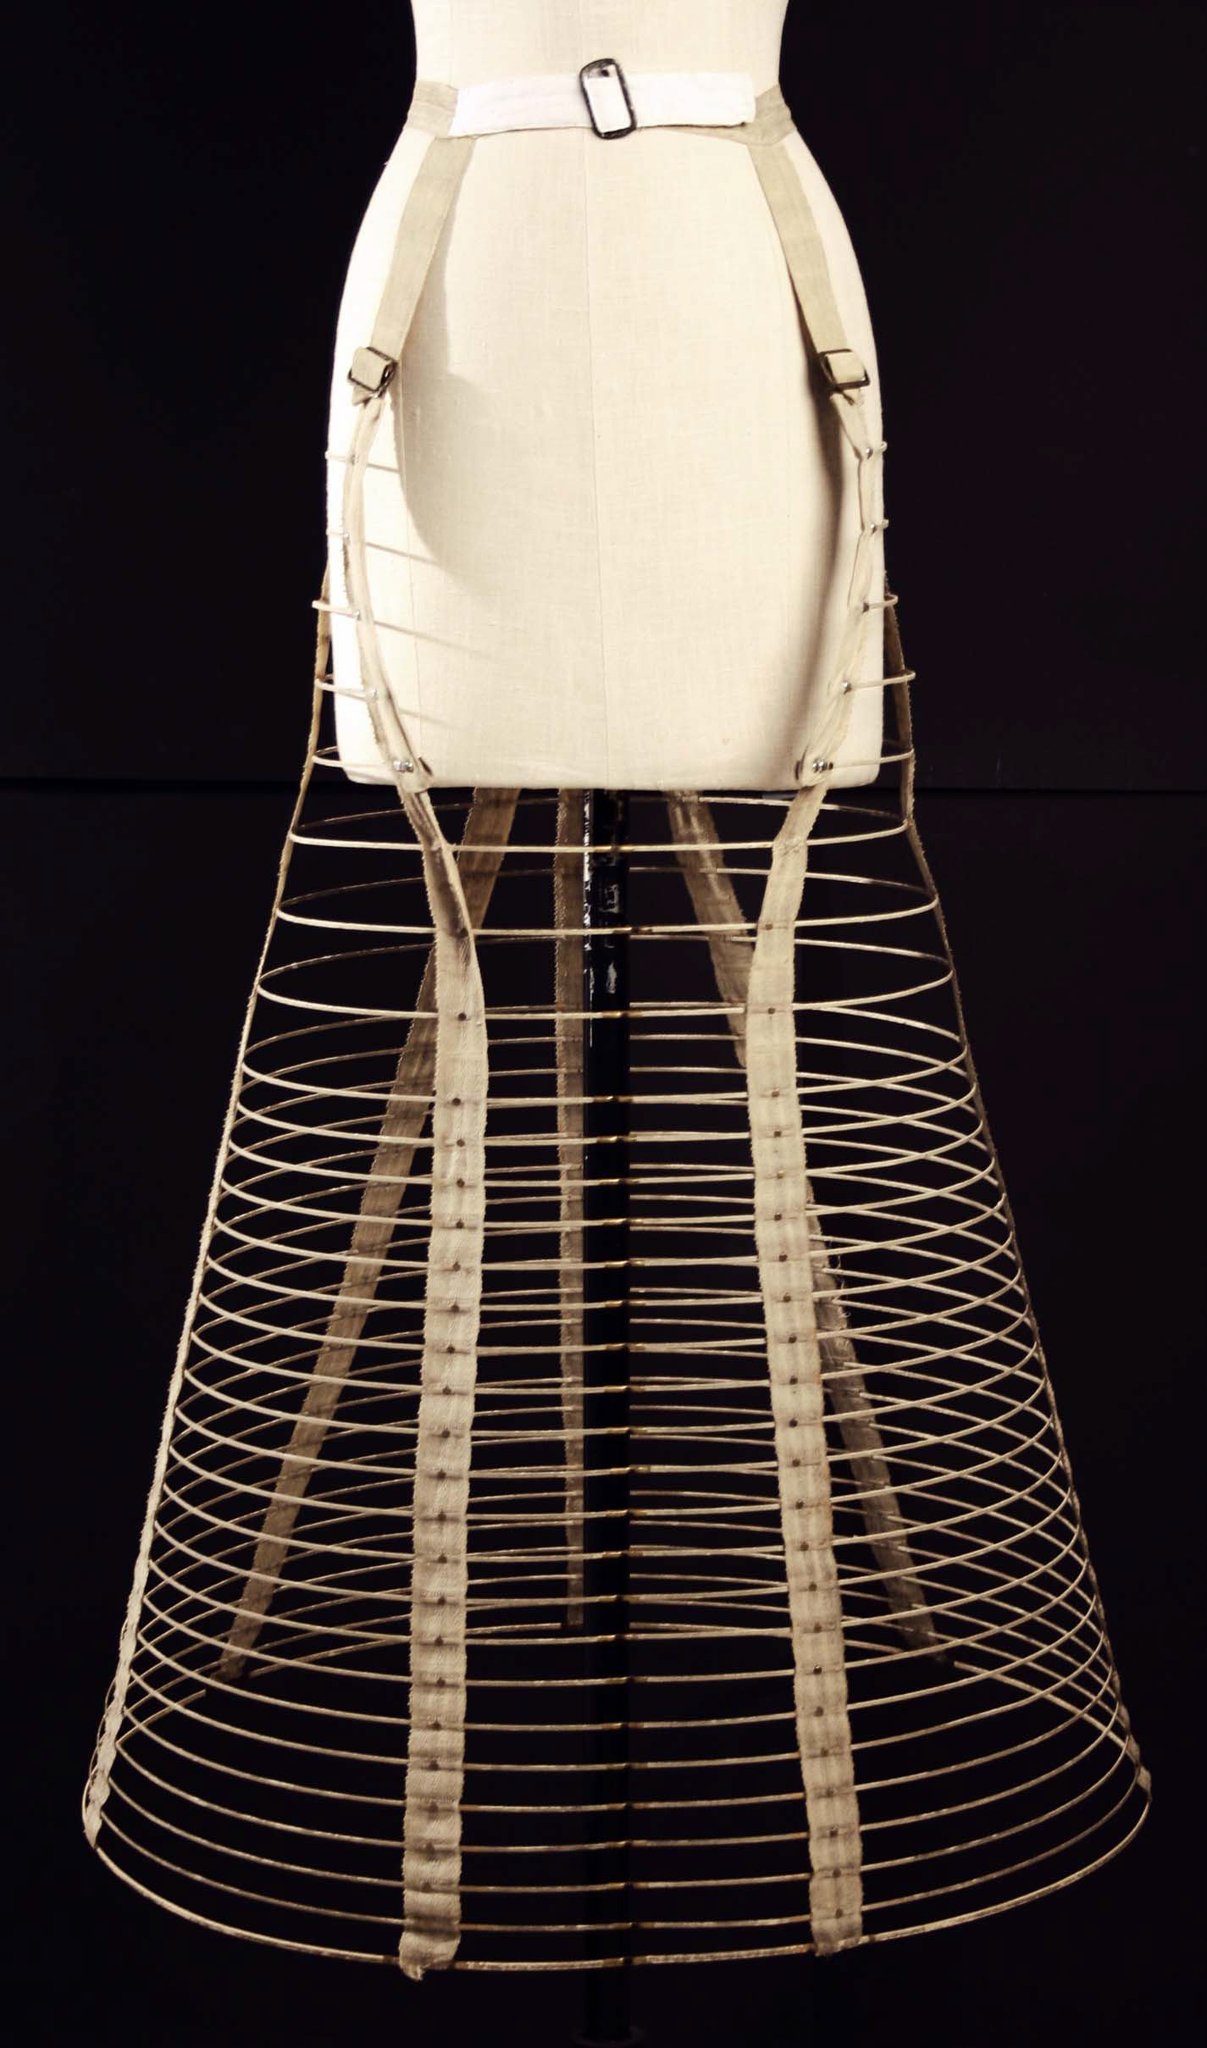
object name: cage crinoline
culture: american or european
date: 1834-1866